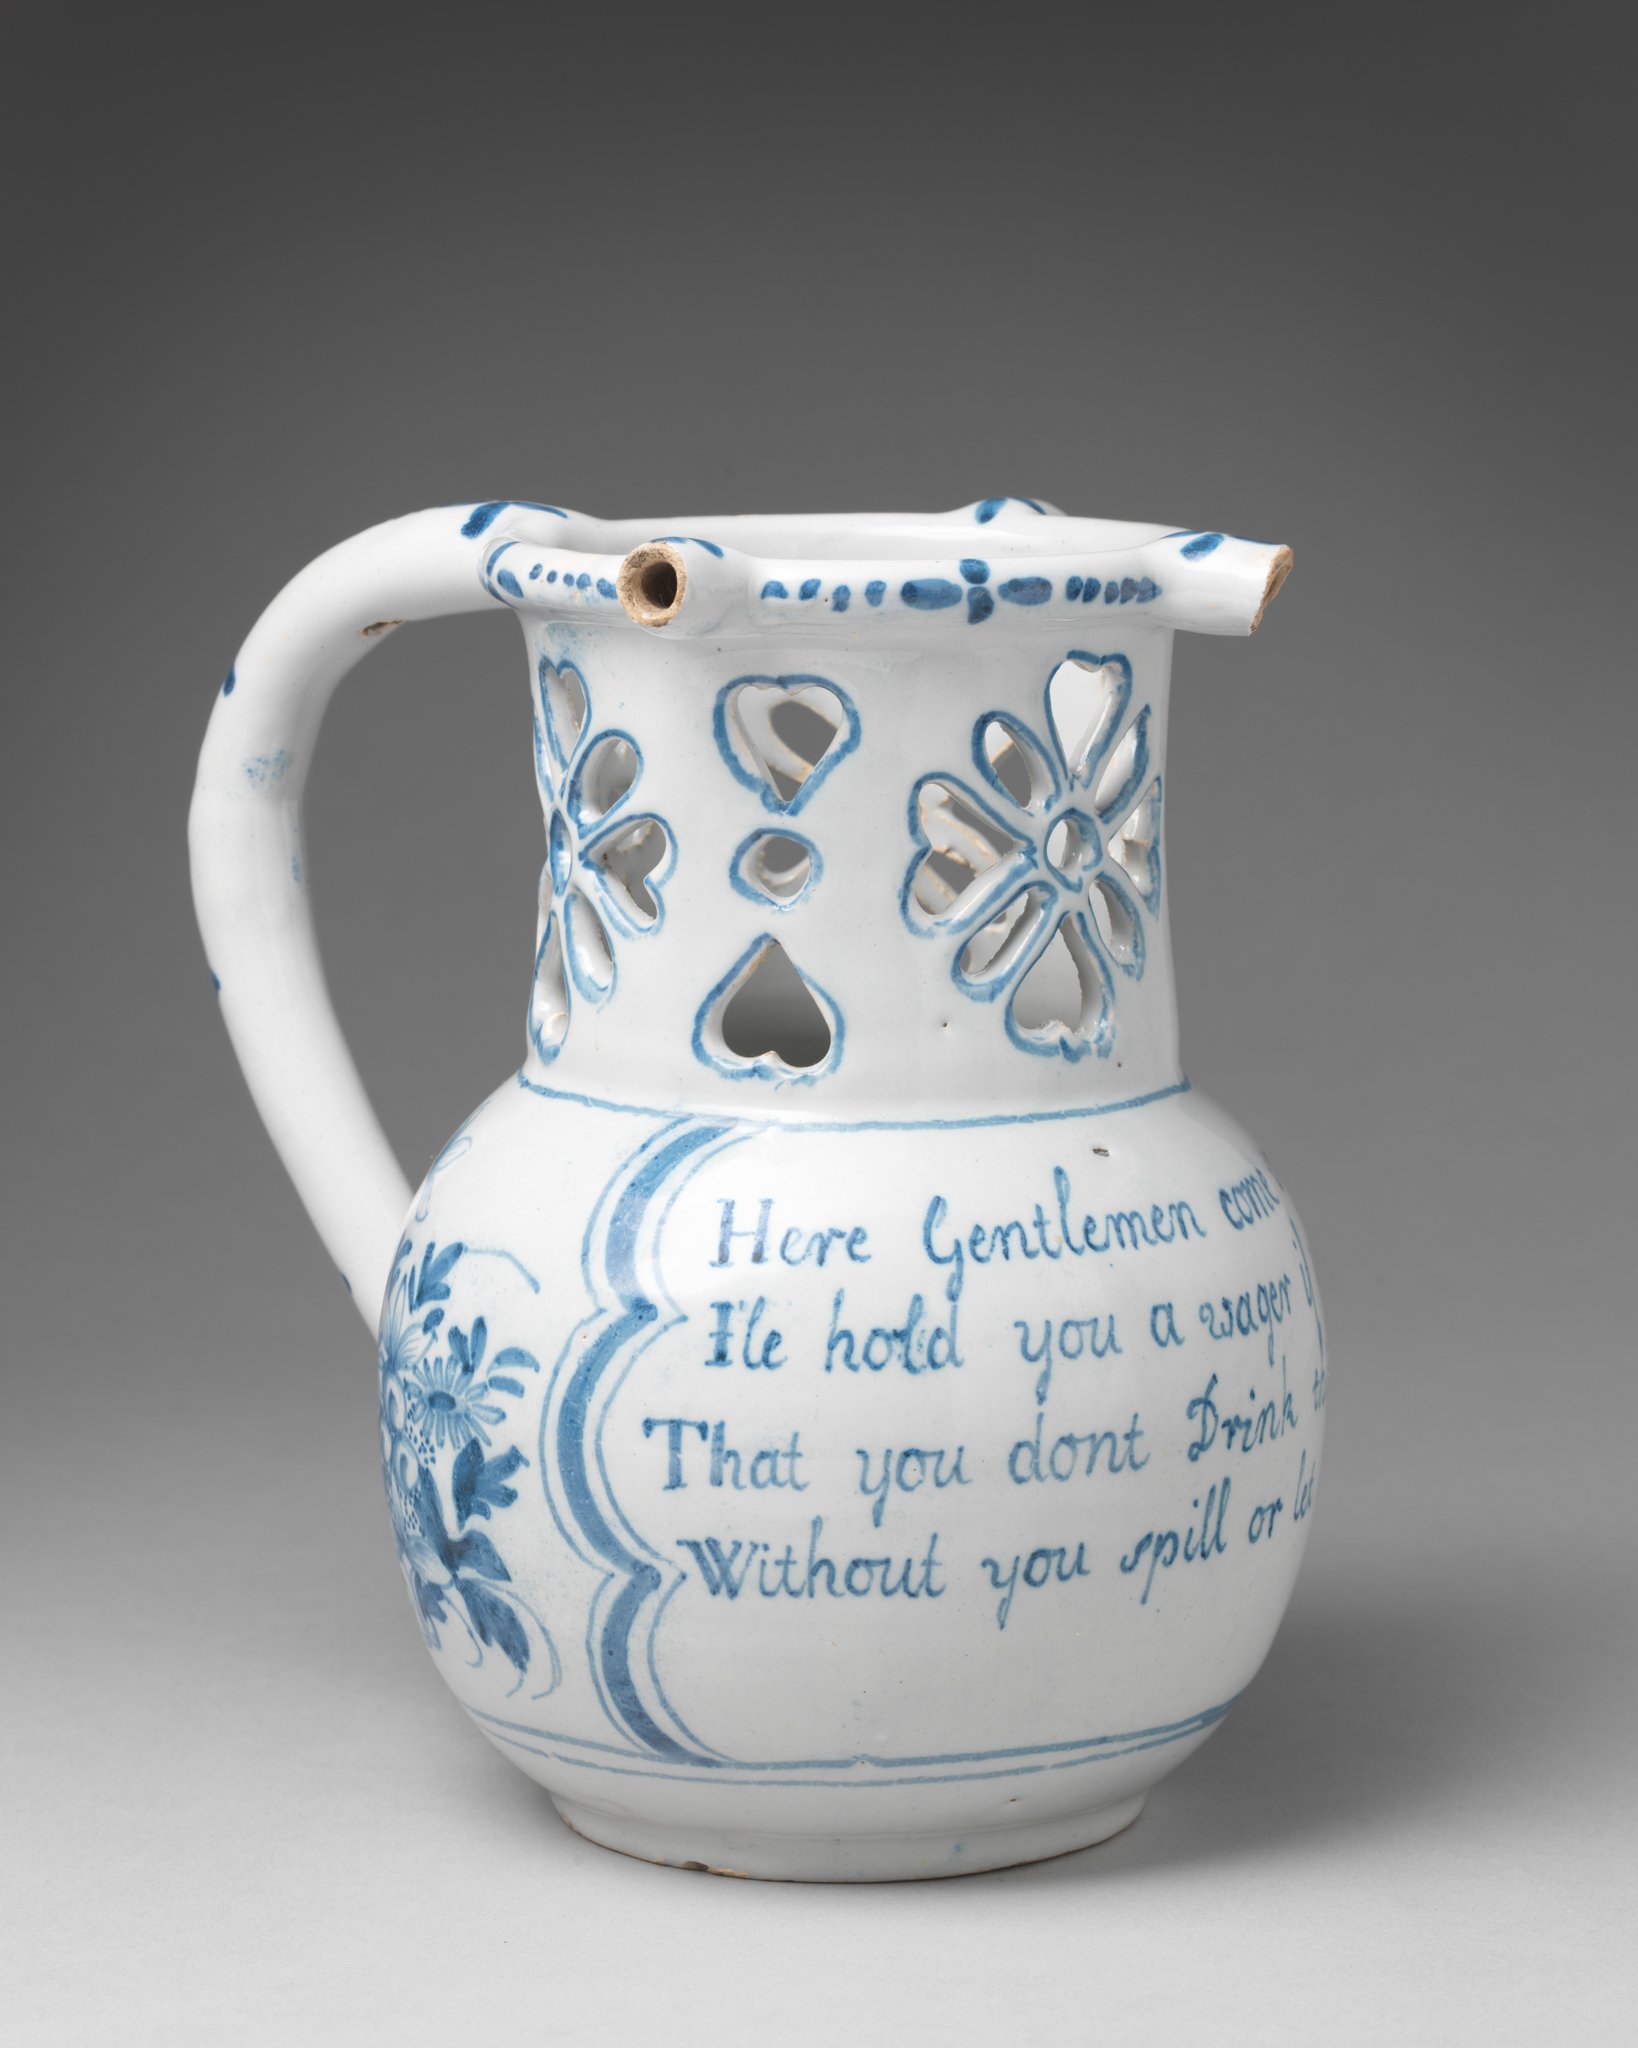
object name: puzzle jug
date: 1701-1800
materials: earthenware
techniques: glazing